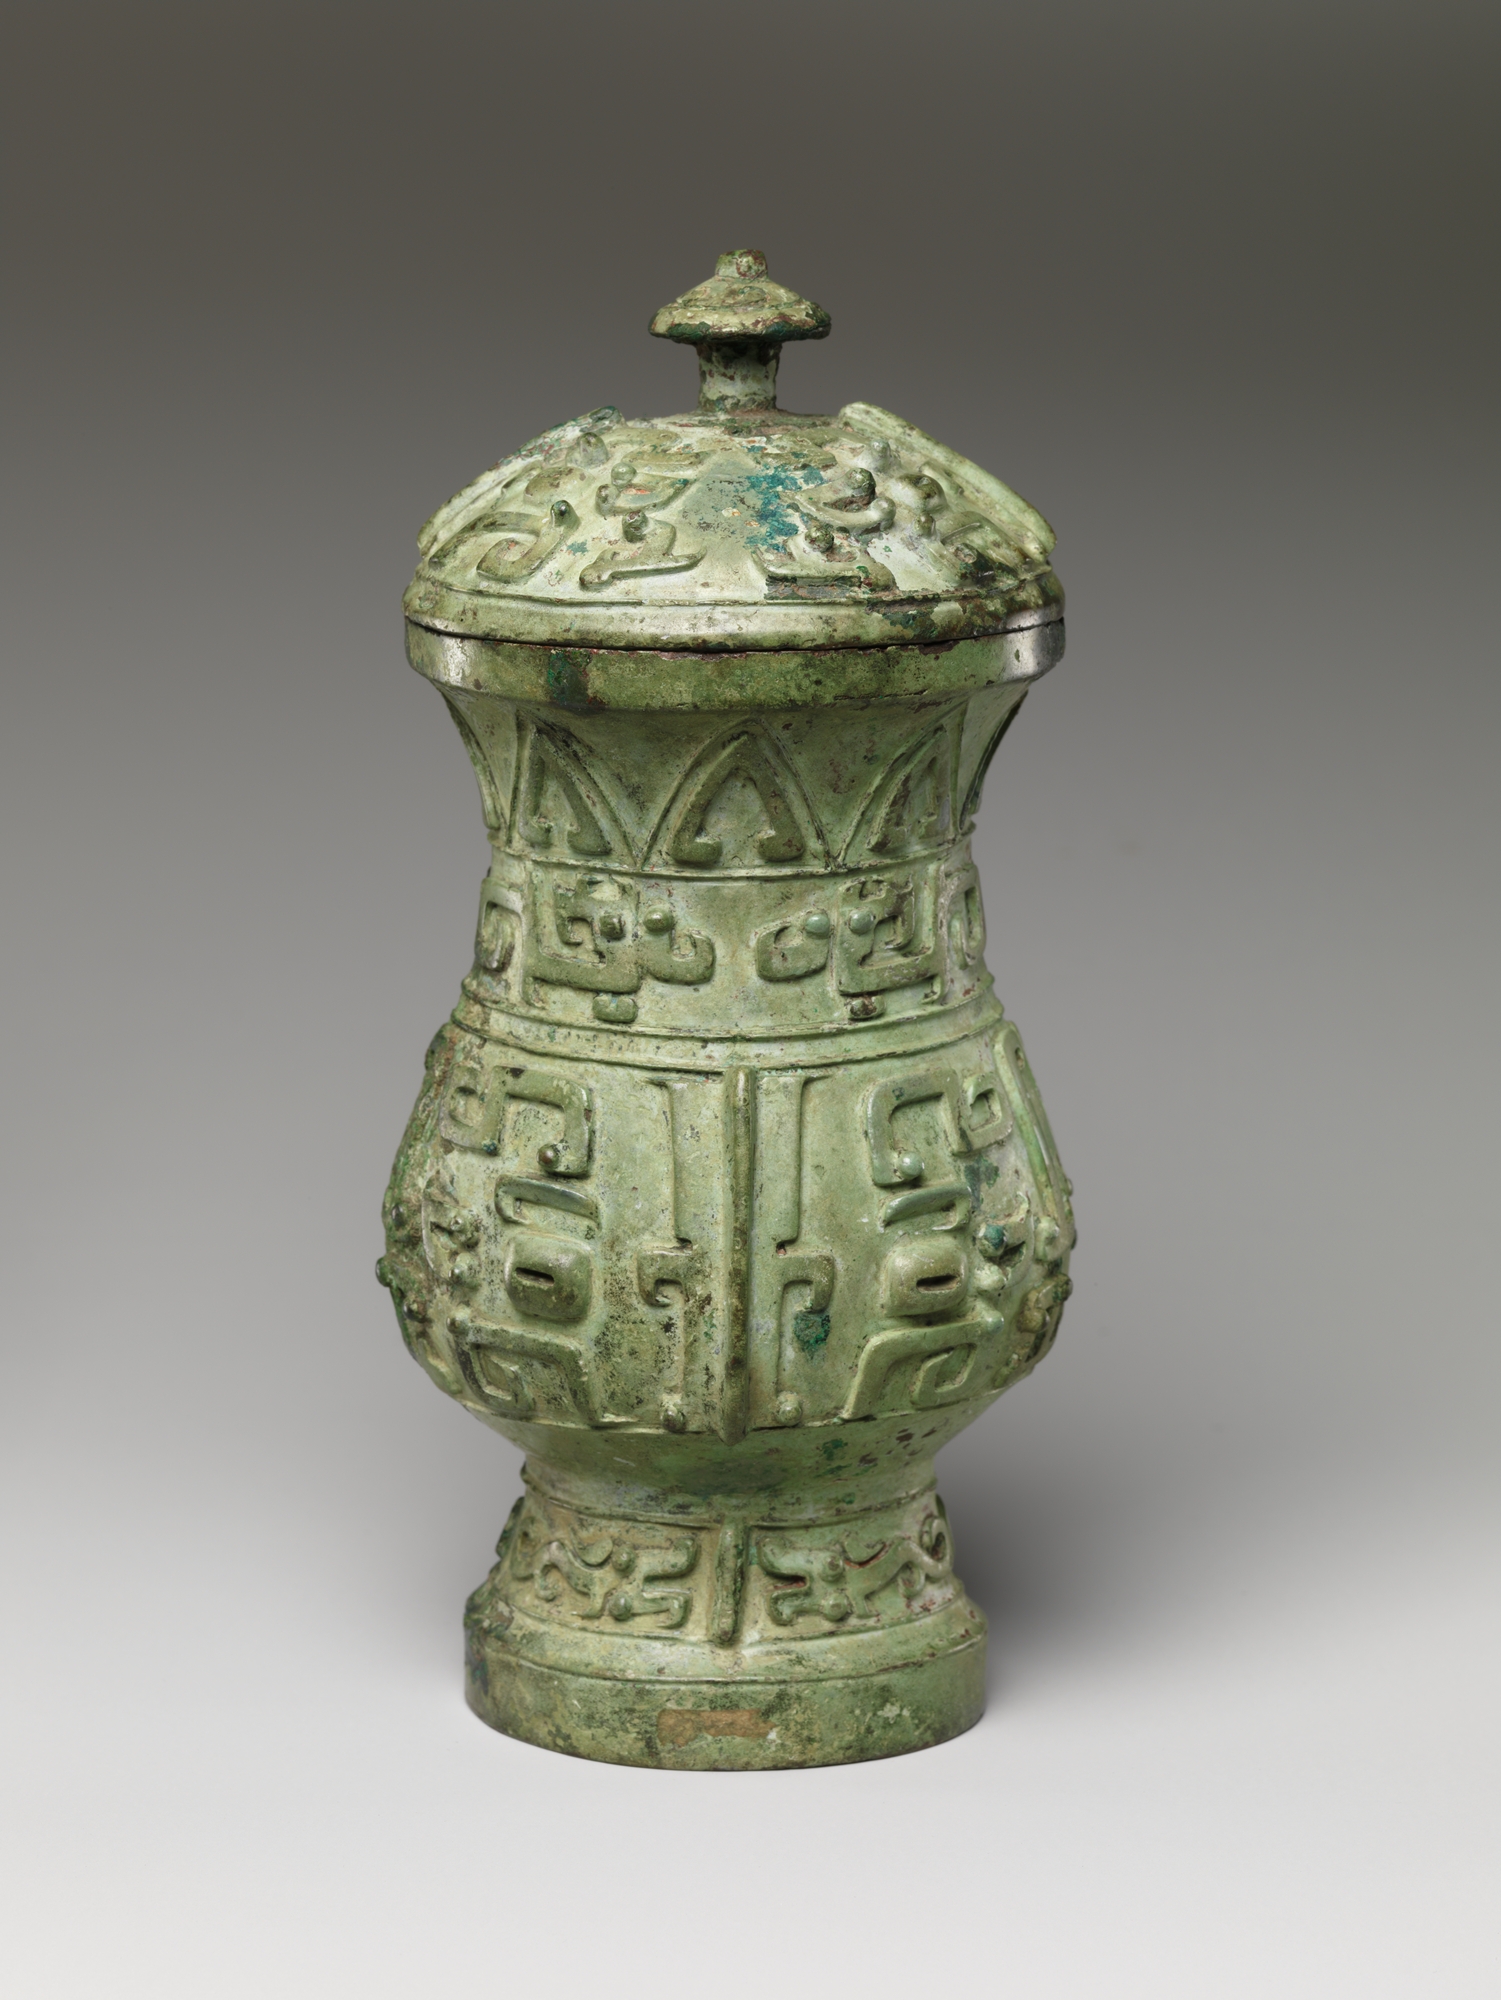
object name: wine vessel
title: Wine Cup (Zhi)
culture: chinese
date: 1100-1001 BCE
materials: bronze